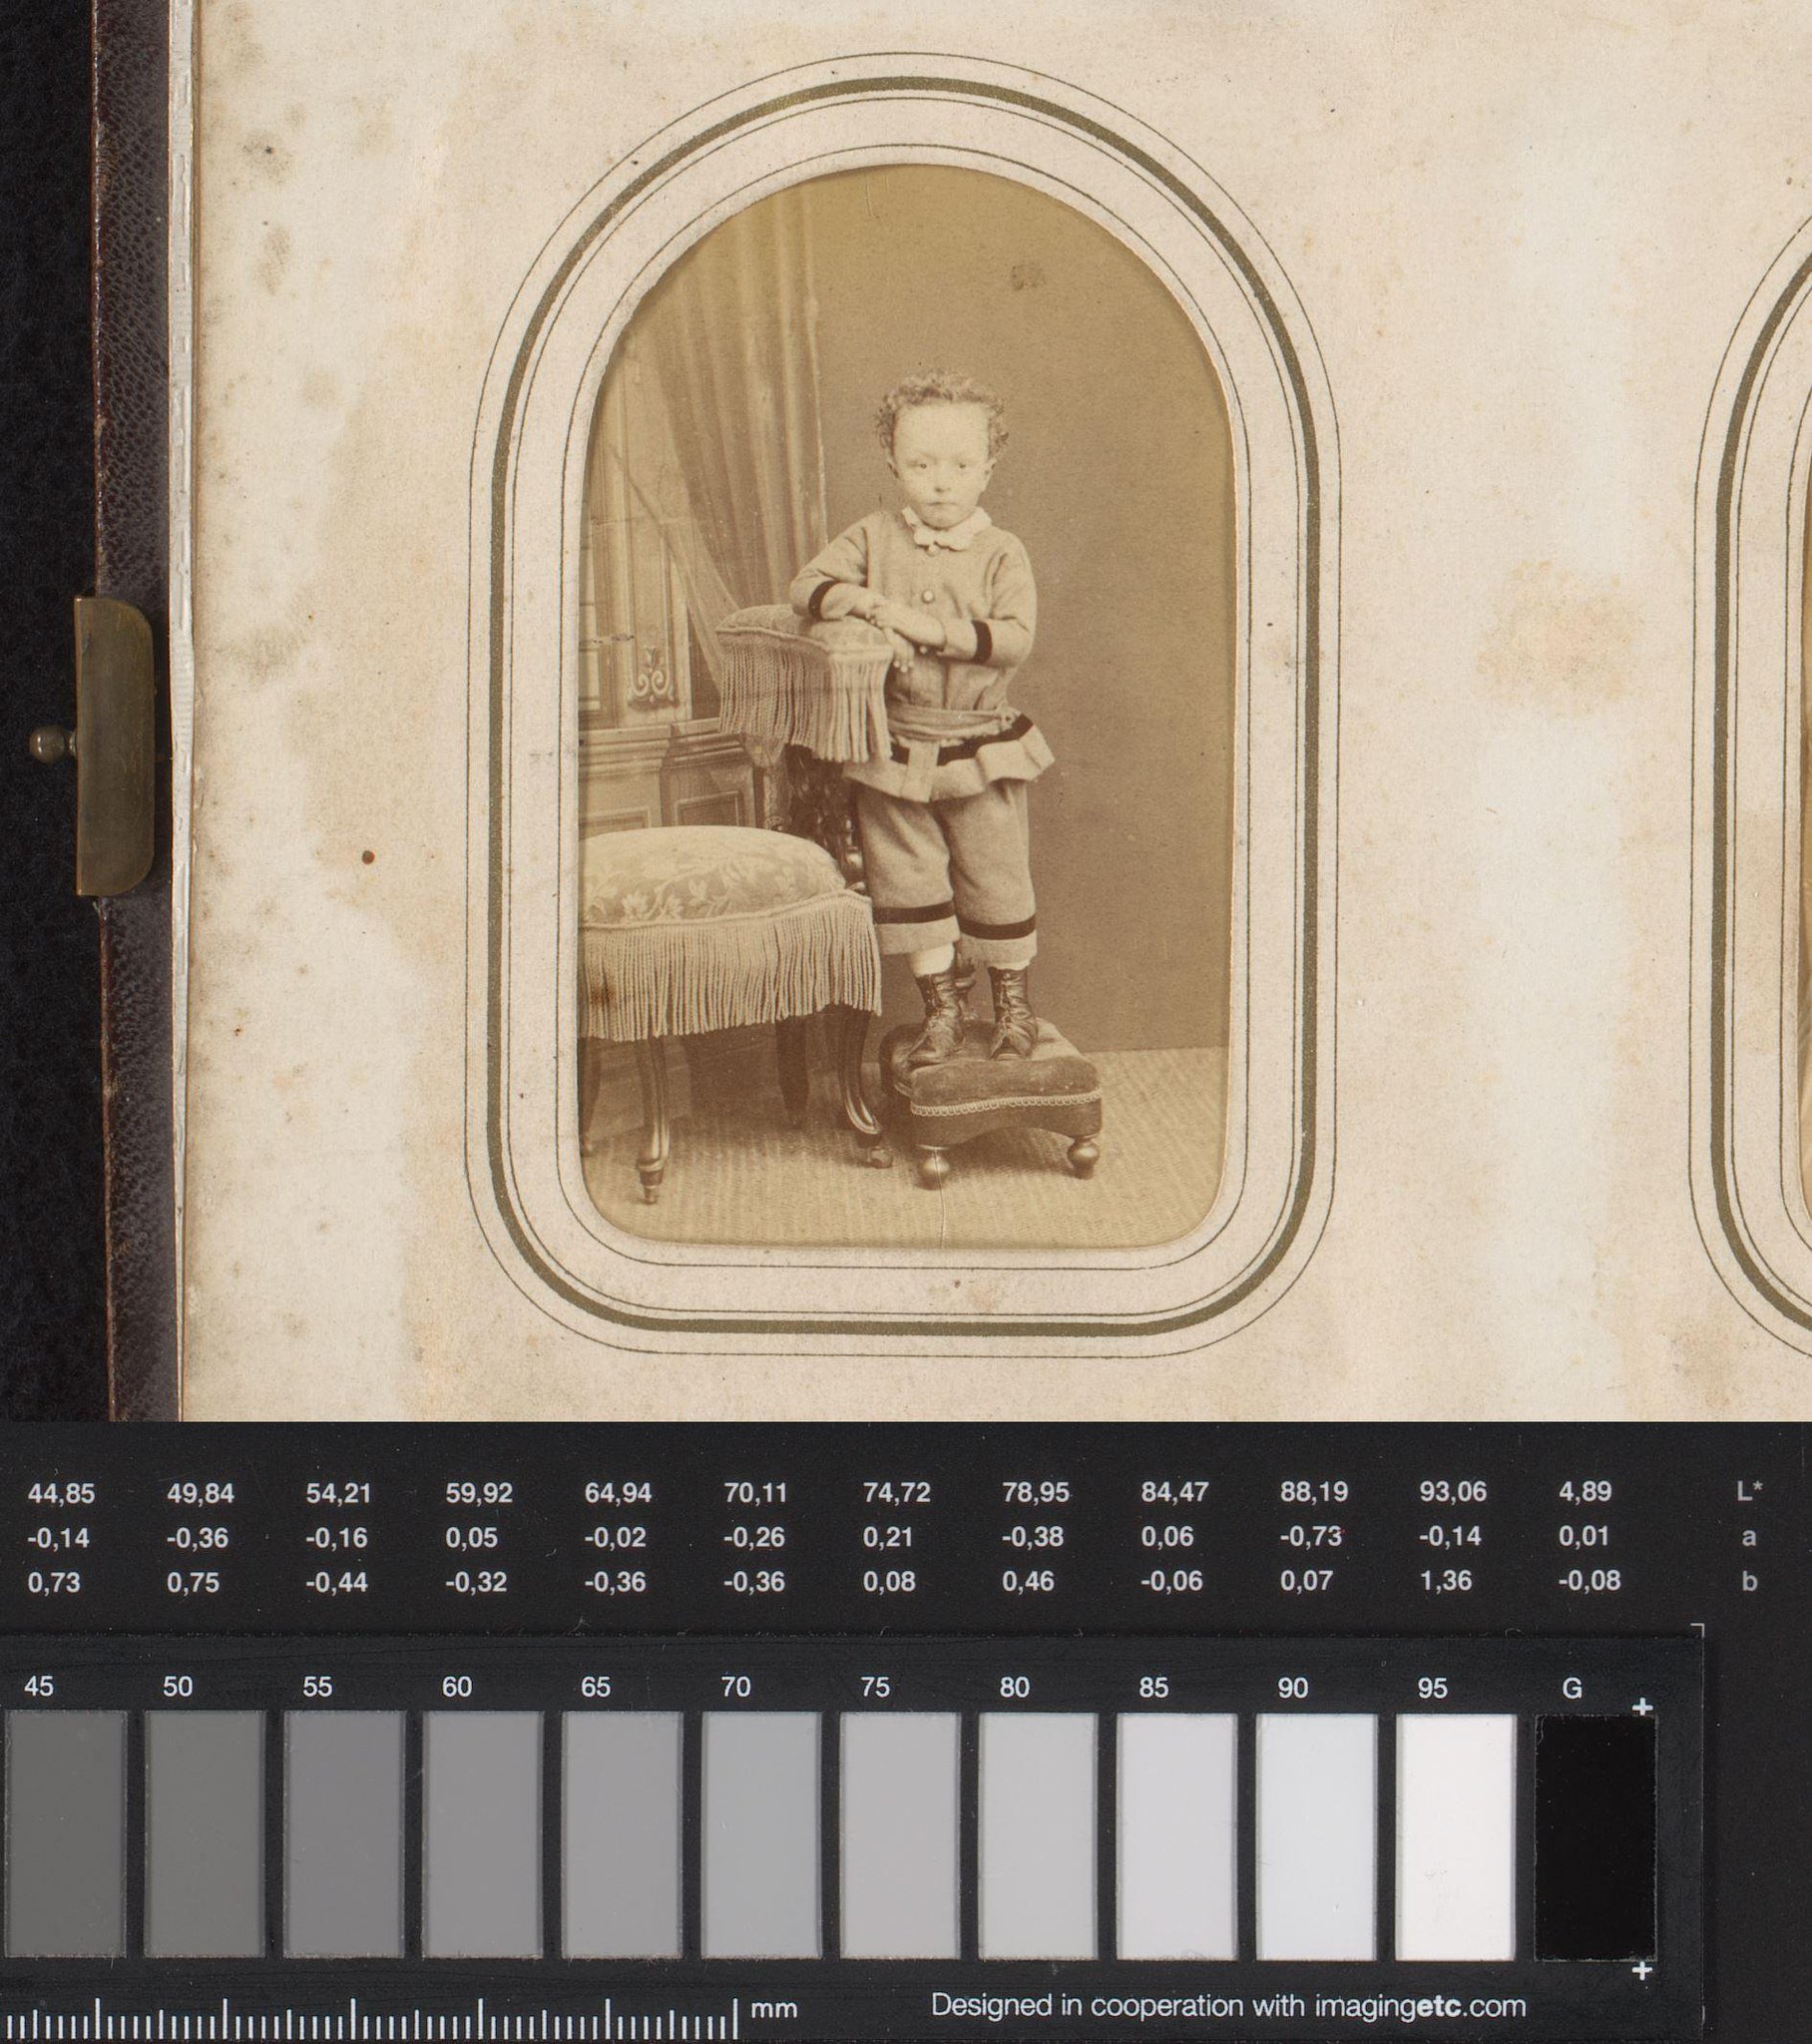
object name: photograph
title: Portret van een jongen, staand bij een bidstoel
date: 1860-1900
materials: cardboard, photographic support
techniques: albumen print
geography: hoorn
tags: kneeling-chair, historical persons, toddler (male)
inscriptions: inscription: ‘Photographie/ F.D. VAN ROSMALEN & ZOON./ NIEUWESTEEG/ HOORN’